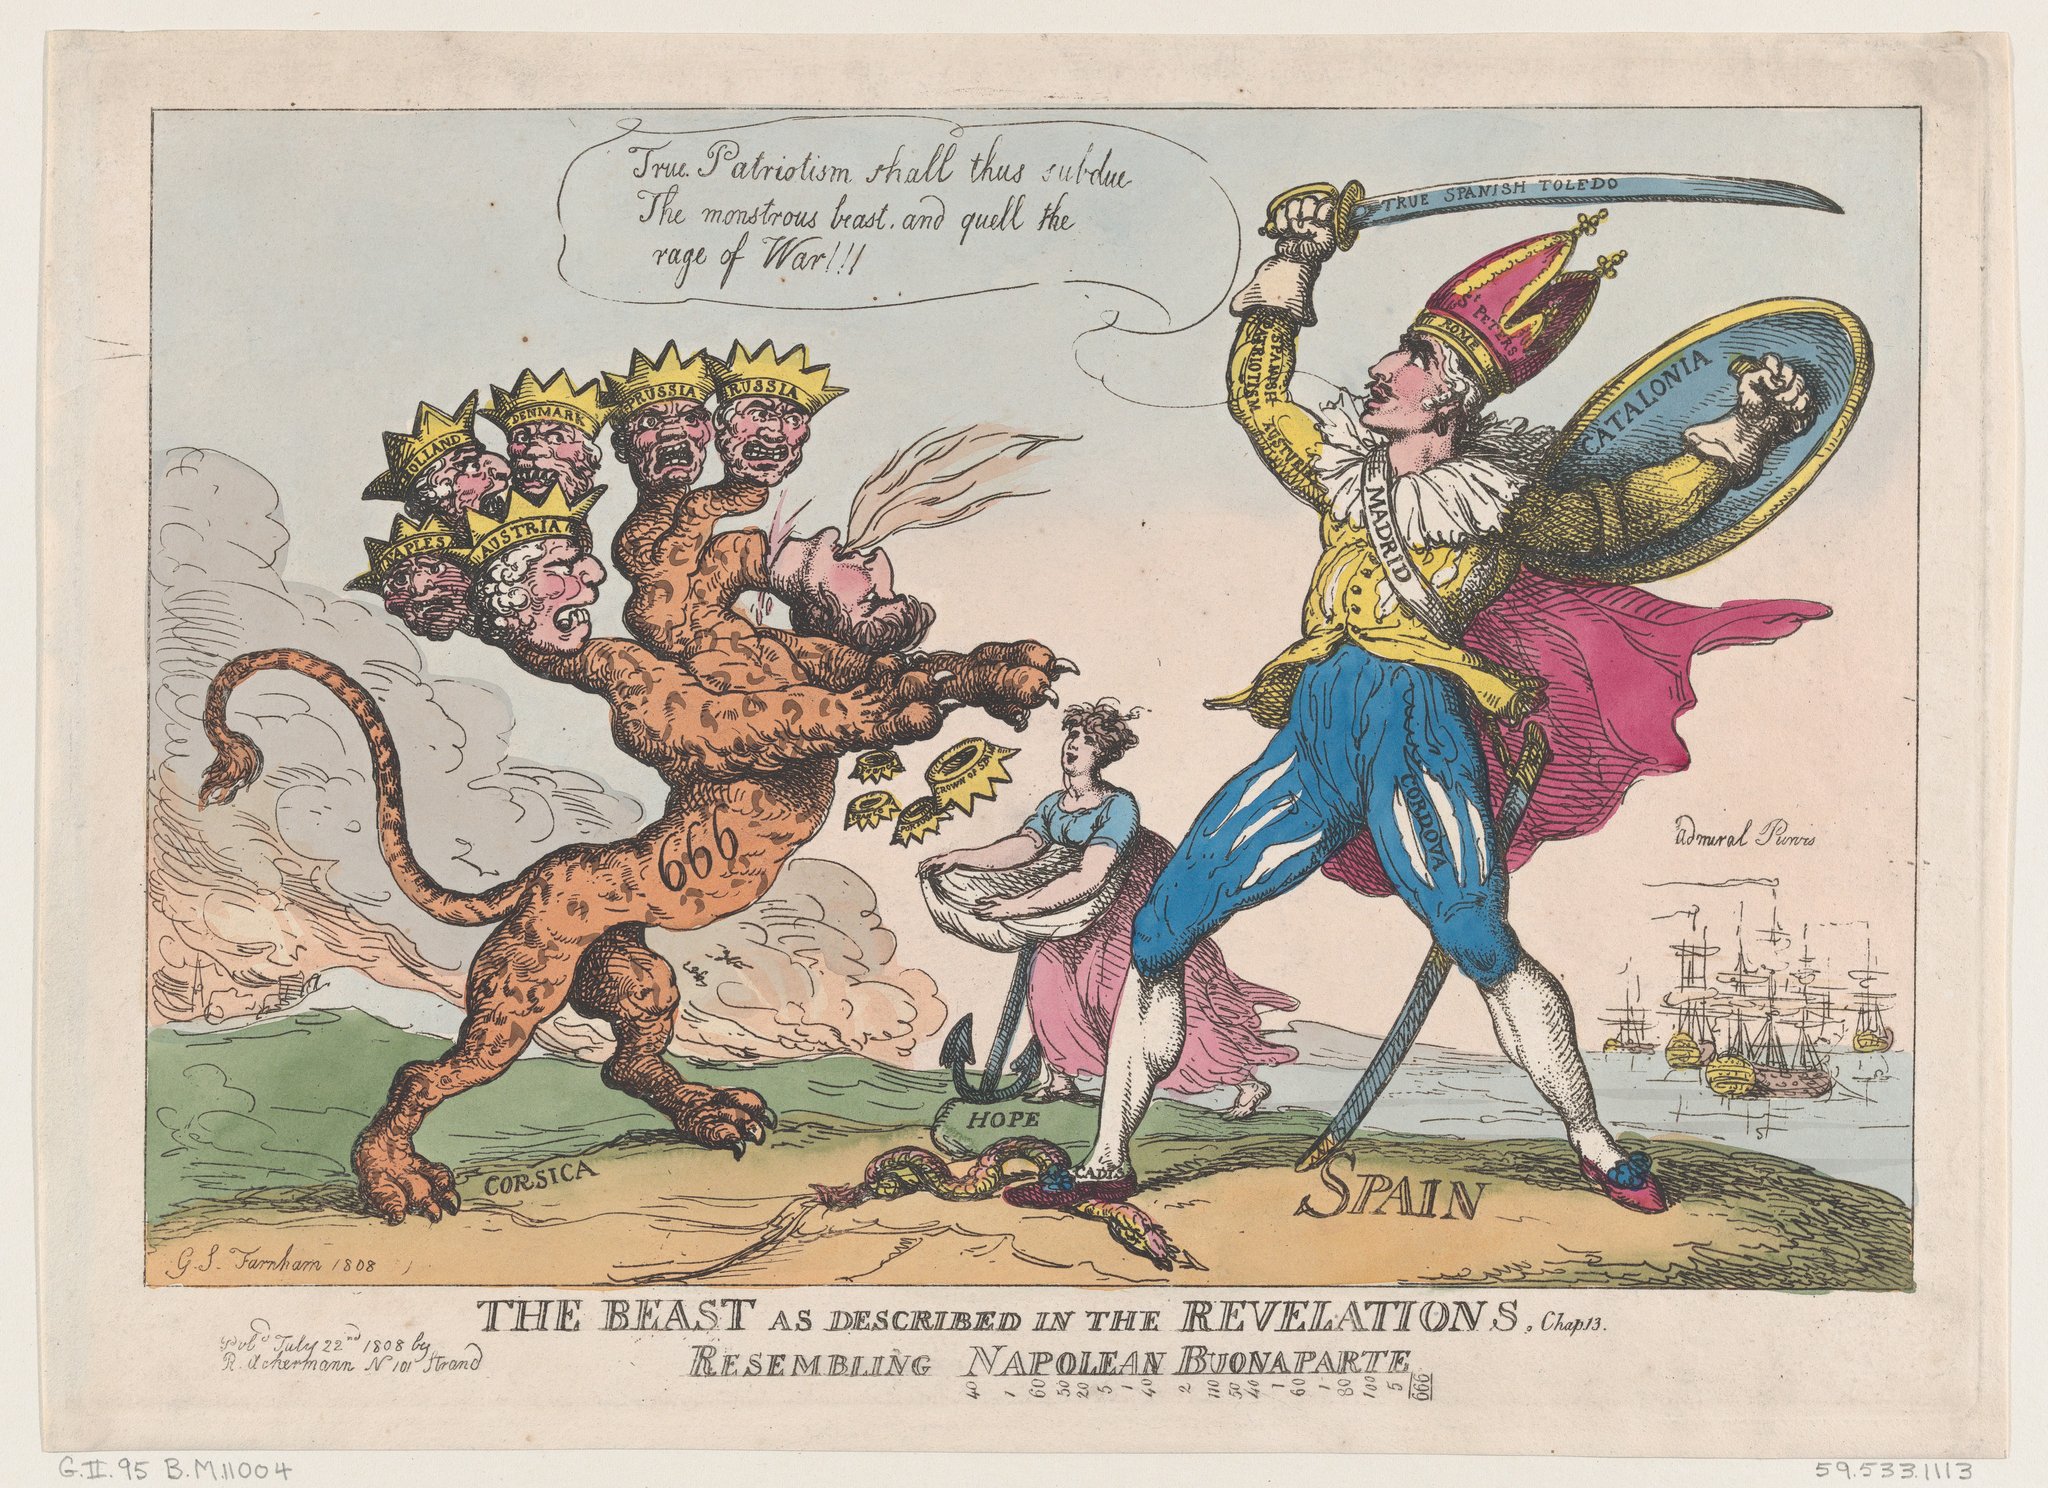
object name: print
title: The Beast As Described In The Revelations, Chap. 13, Resembling Napoleon Buonaparte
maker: thomas rowlandson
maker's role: artist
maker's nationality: british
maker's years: 1757-1827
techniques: etching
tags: satire,men,women,politics